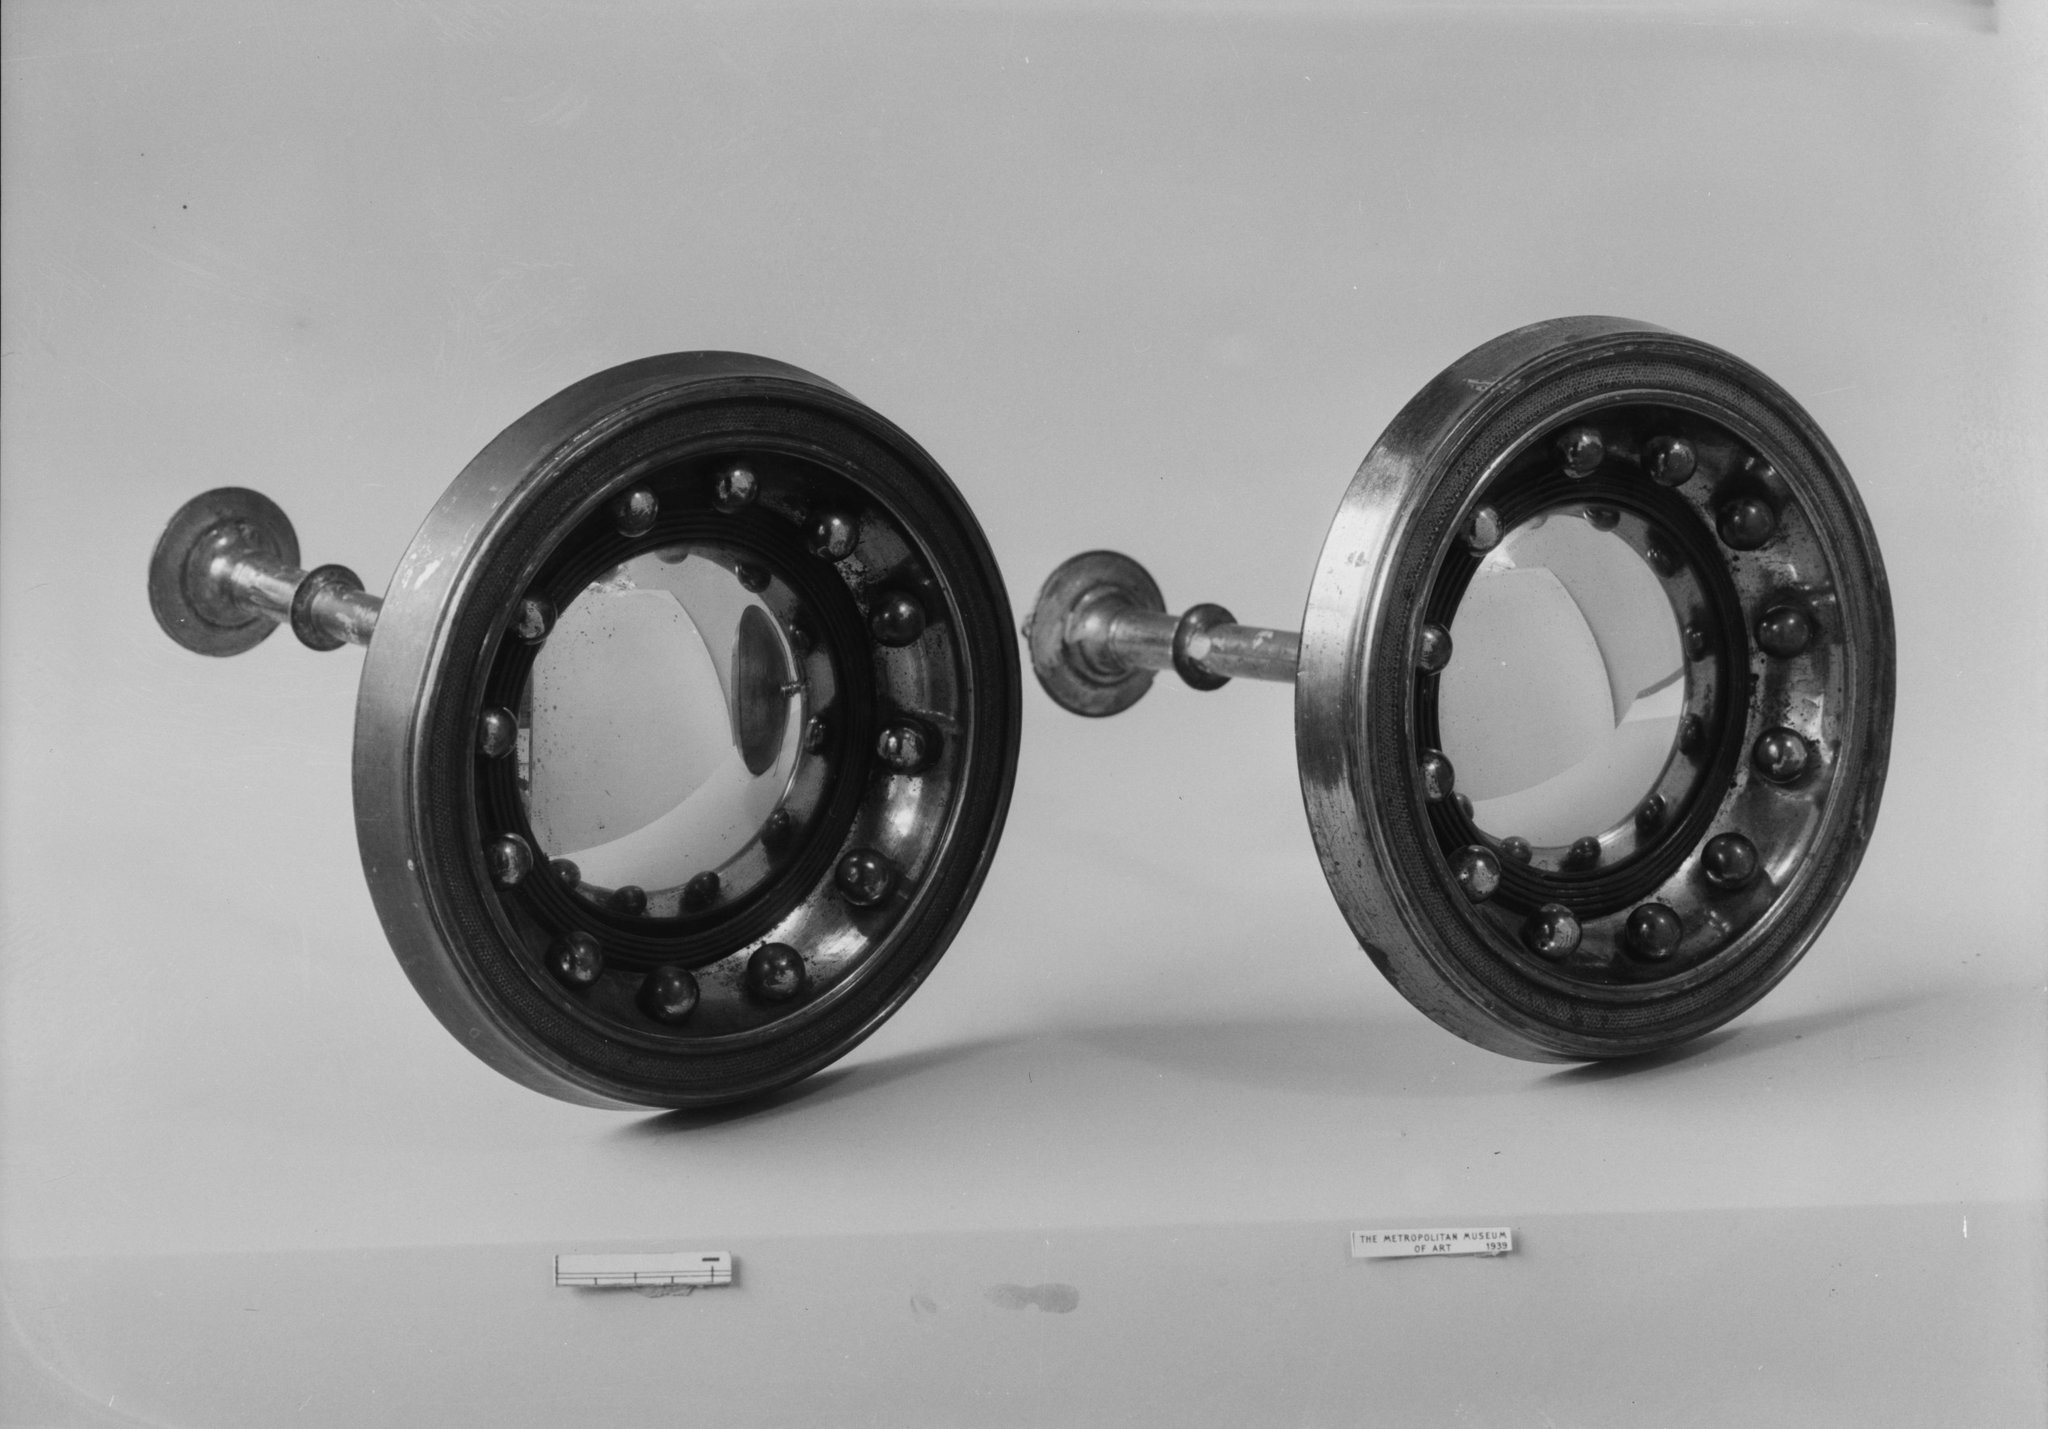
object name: curtain knob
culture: american or british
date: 1800-1900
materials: brass, glass, wood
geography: england